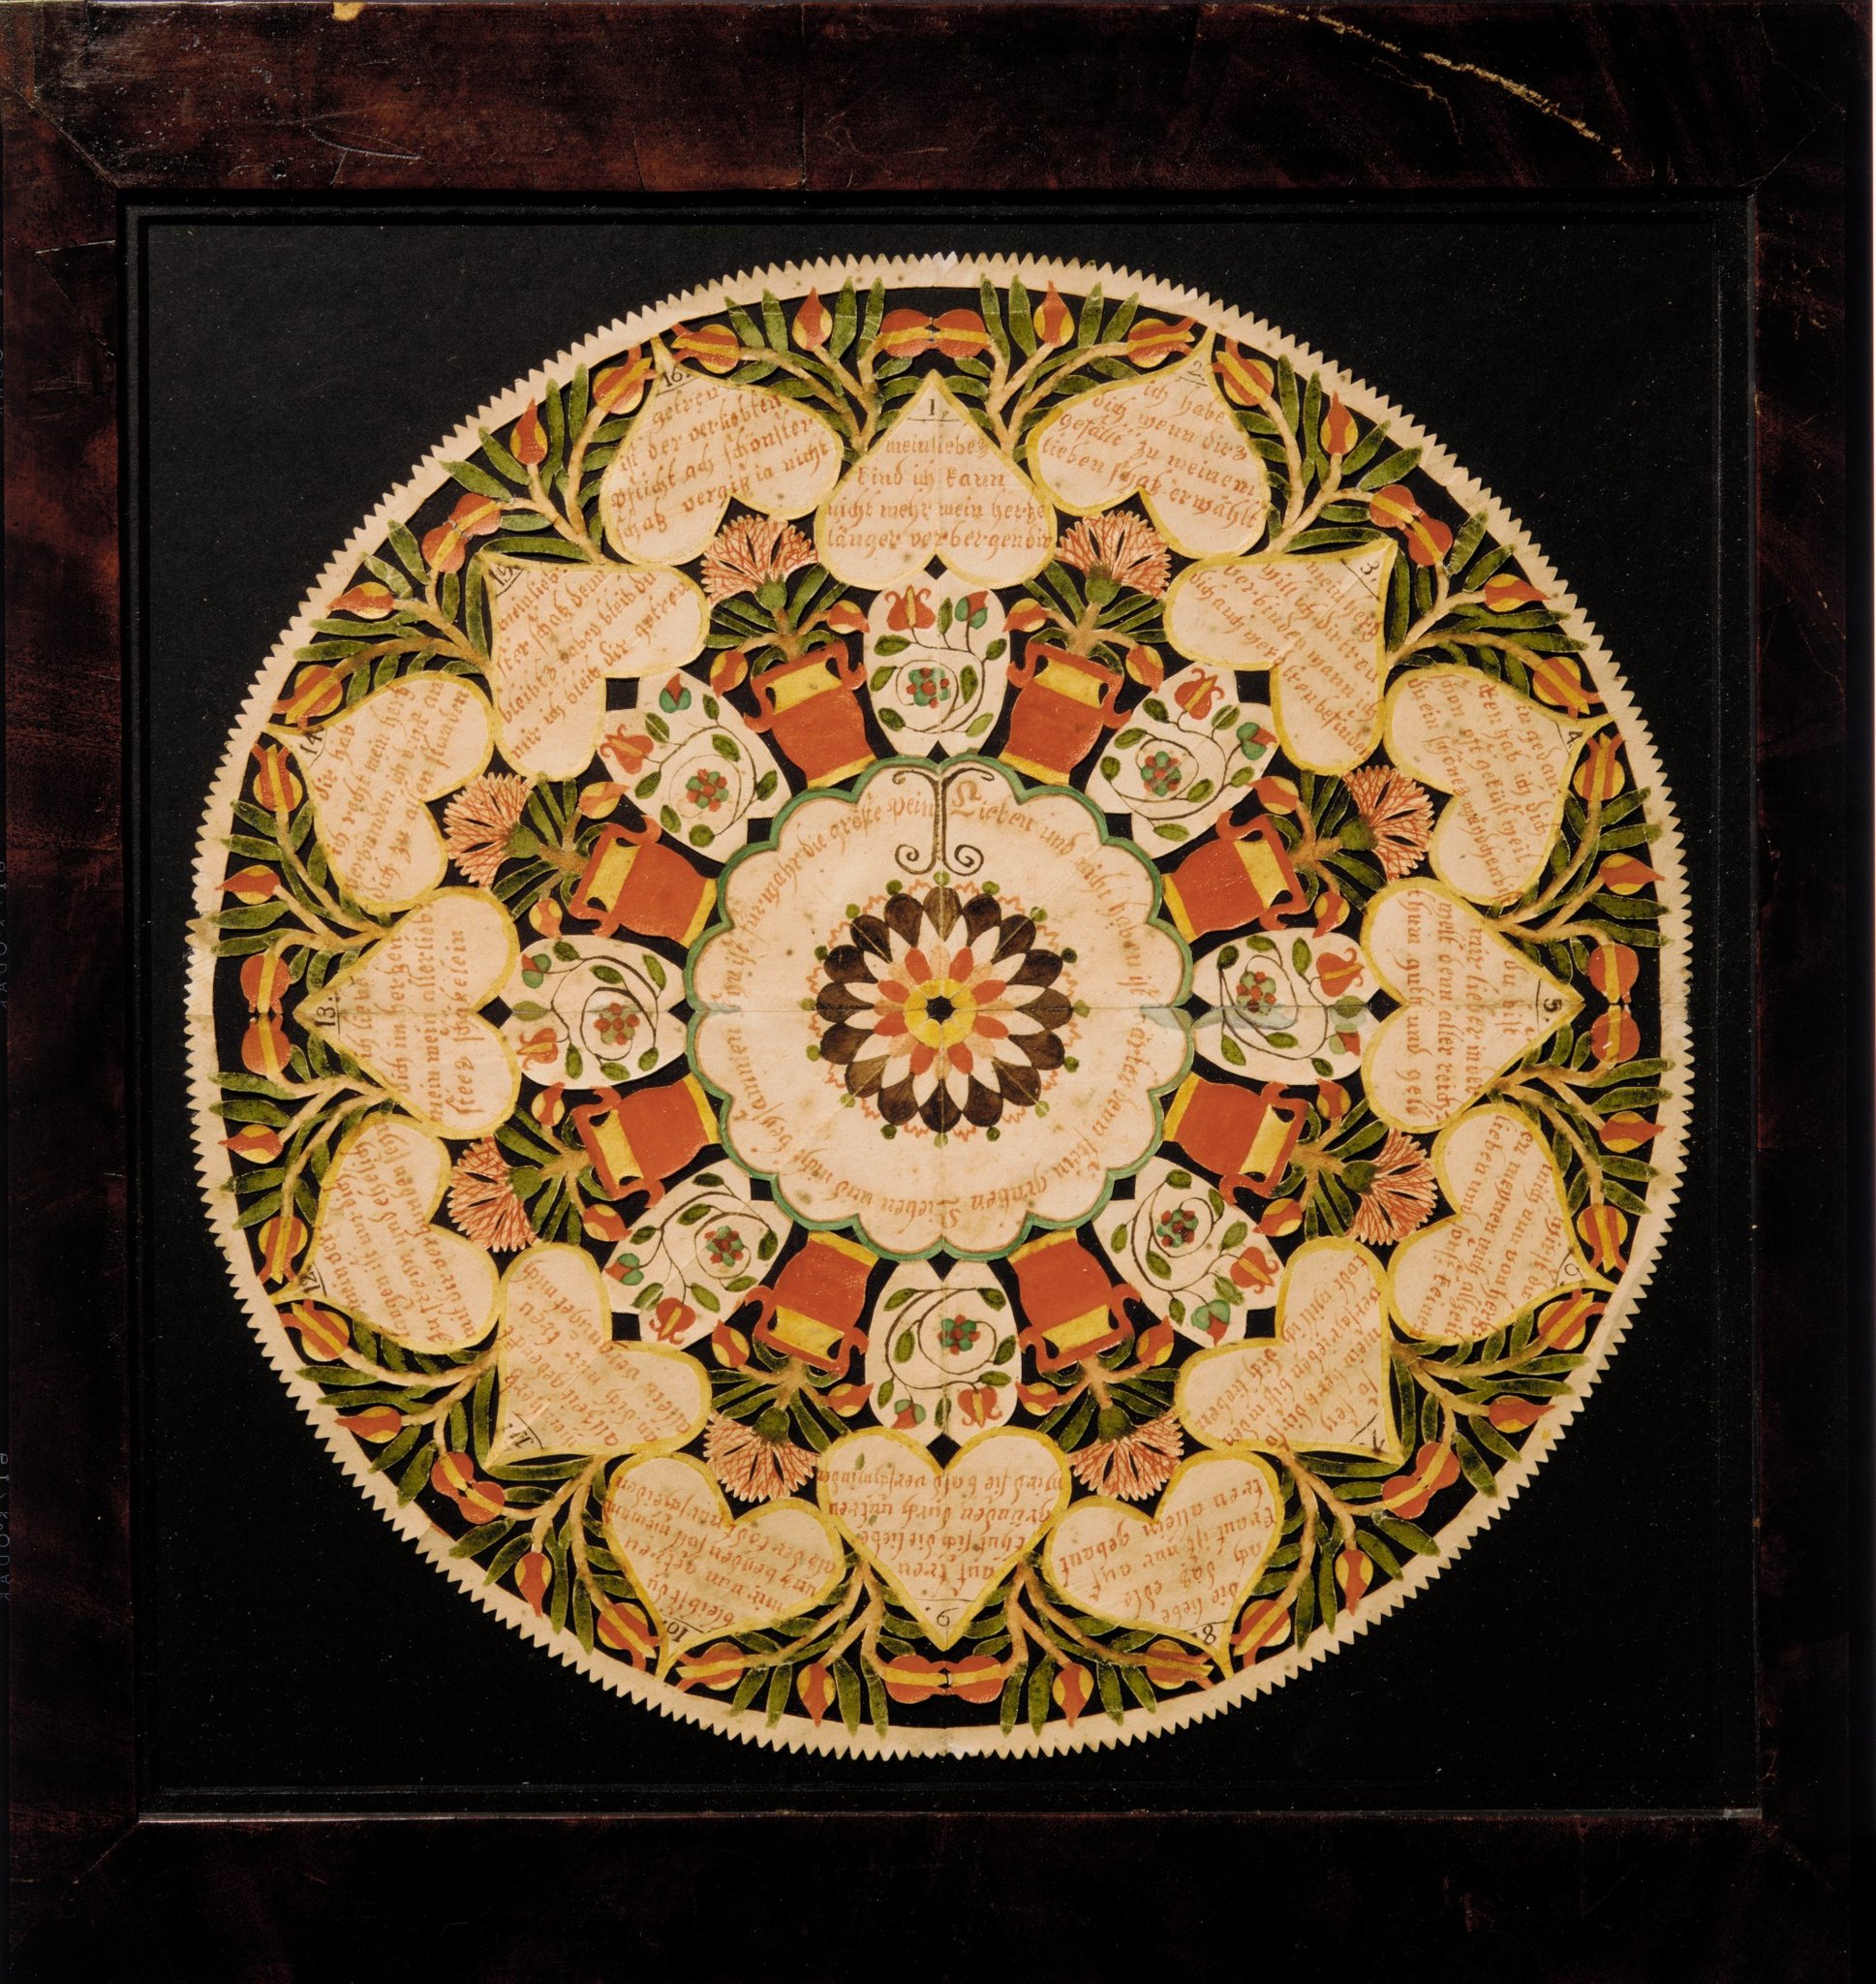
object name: love token, fraktur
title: Love Token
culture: american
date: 1800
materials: paper, watercolor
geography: united states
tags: flowers